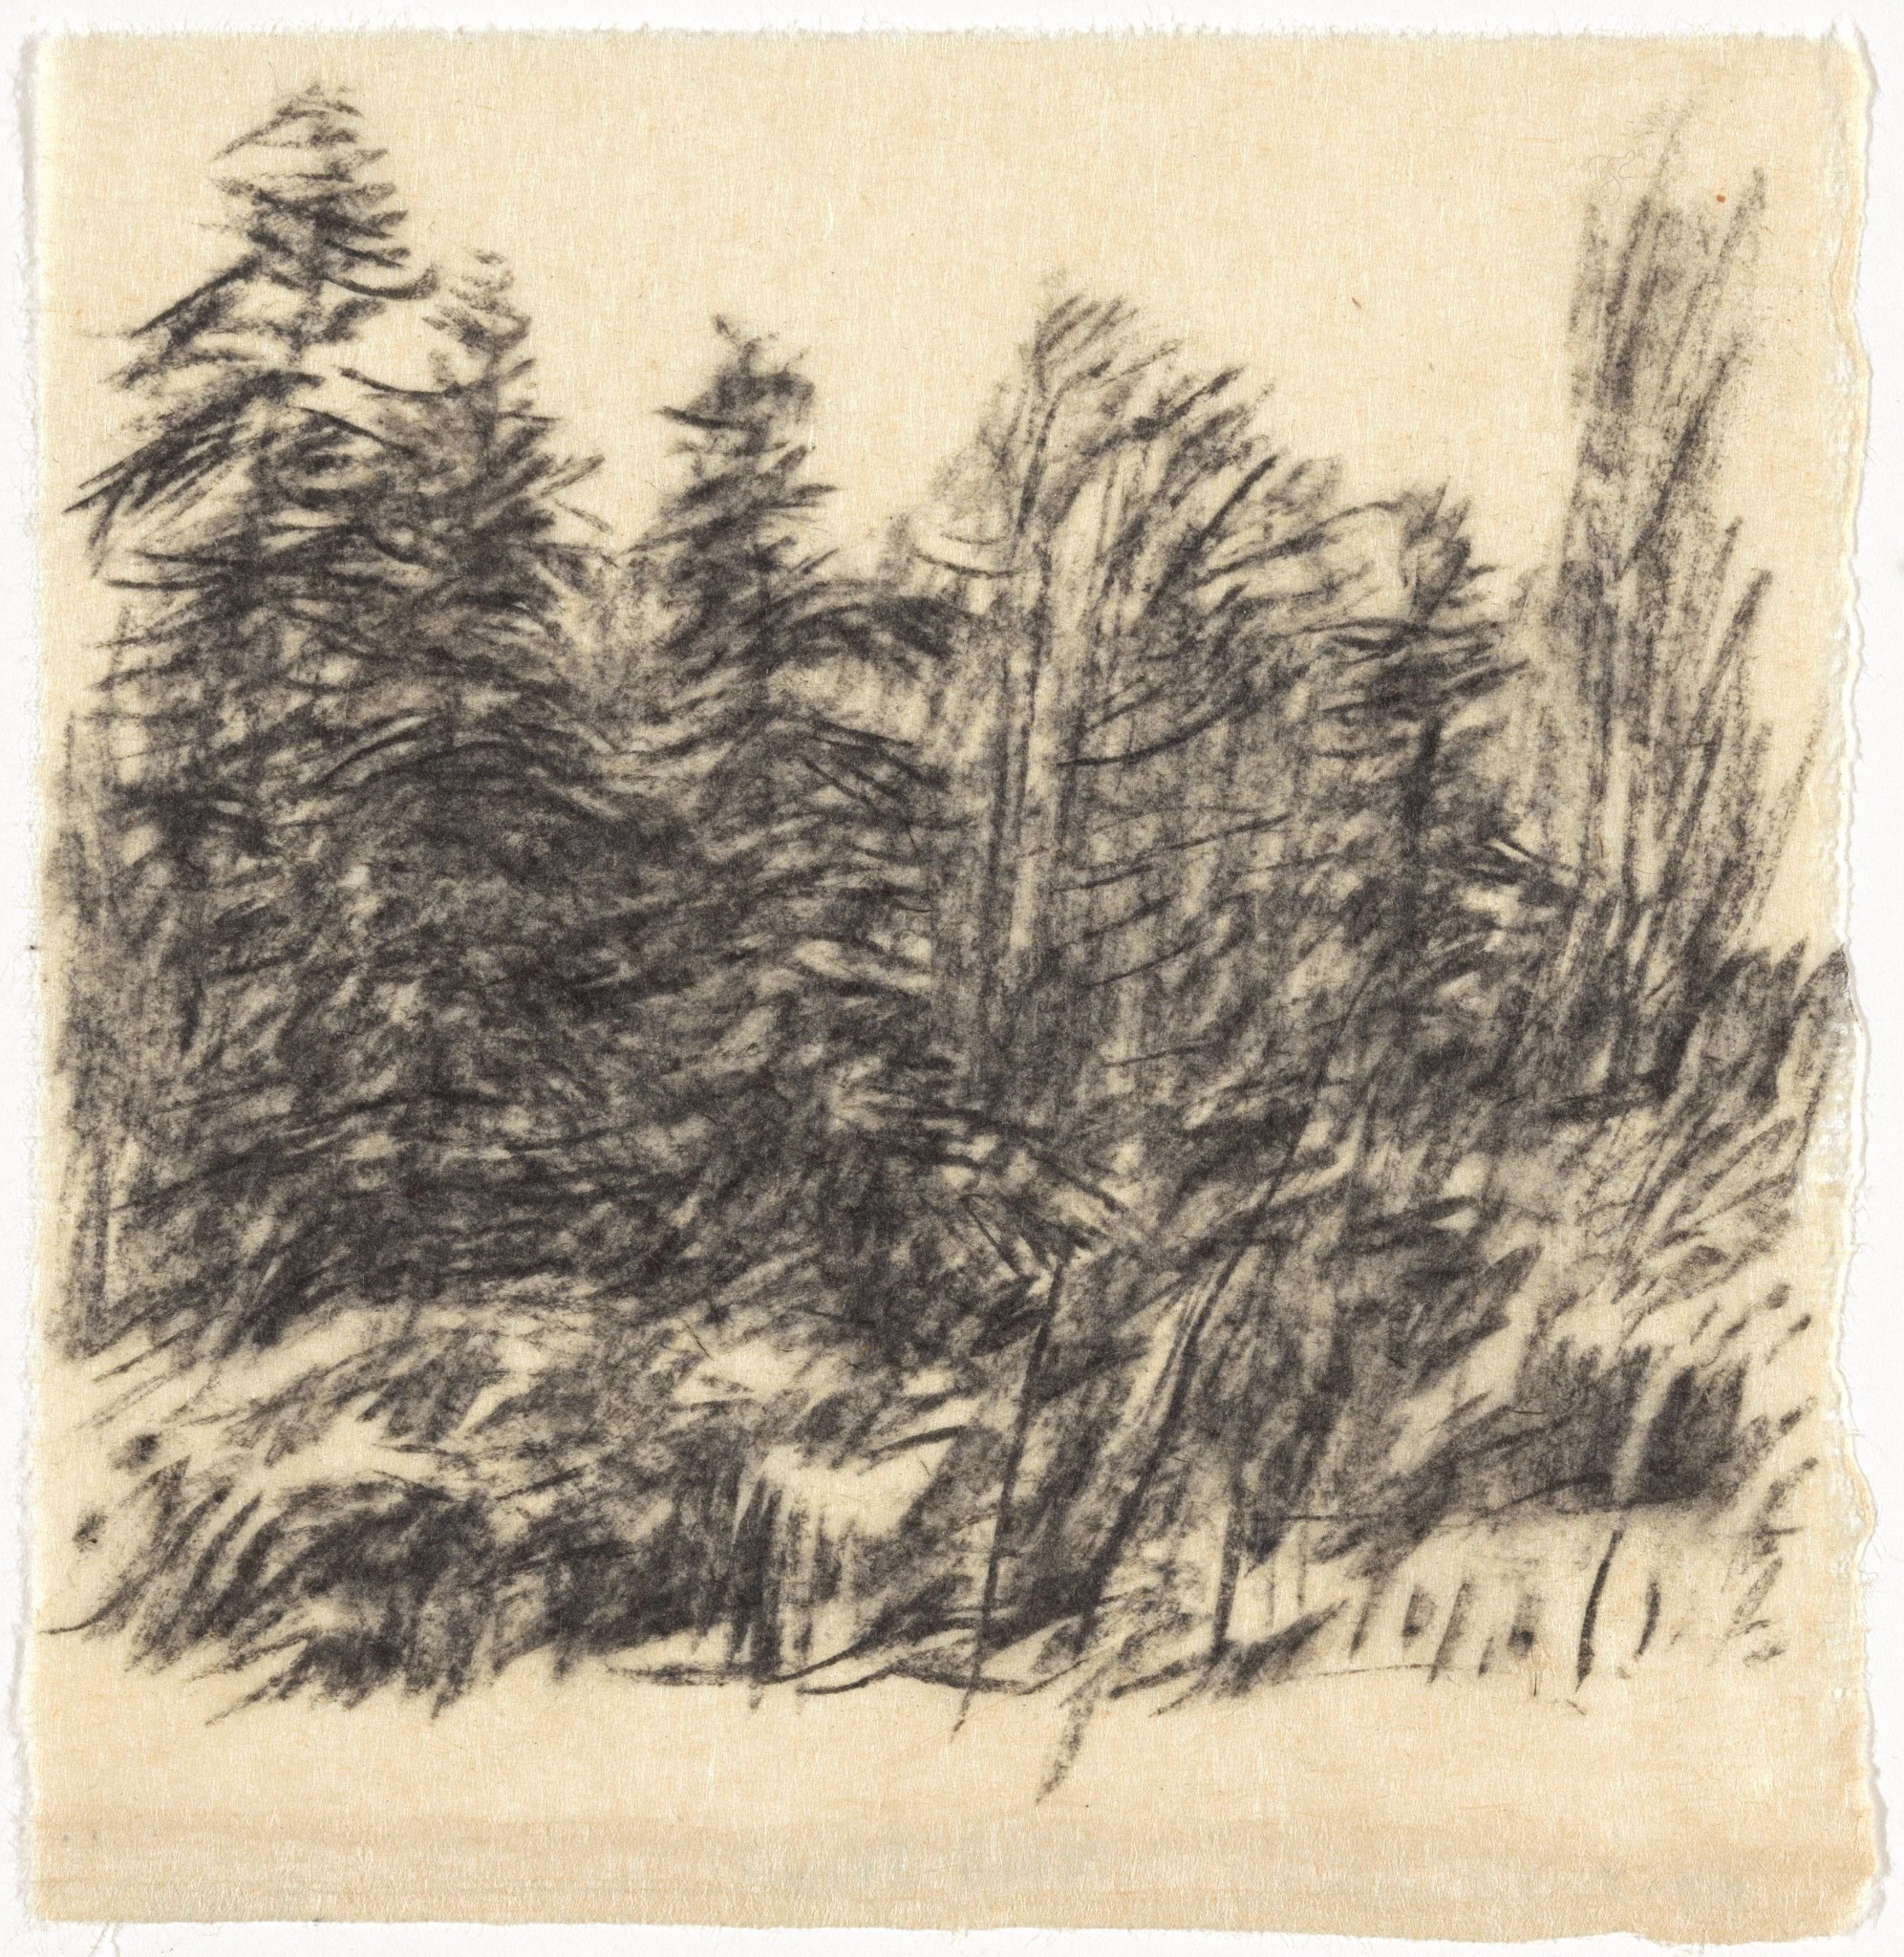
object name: drawing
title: Naaldbomen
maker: kees stoop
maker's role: draughtsman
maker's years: 1929-2019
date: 1939-2009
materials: charcoal, paper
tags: forest of coniferous trees